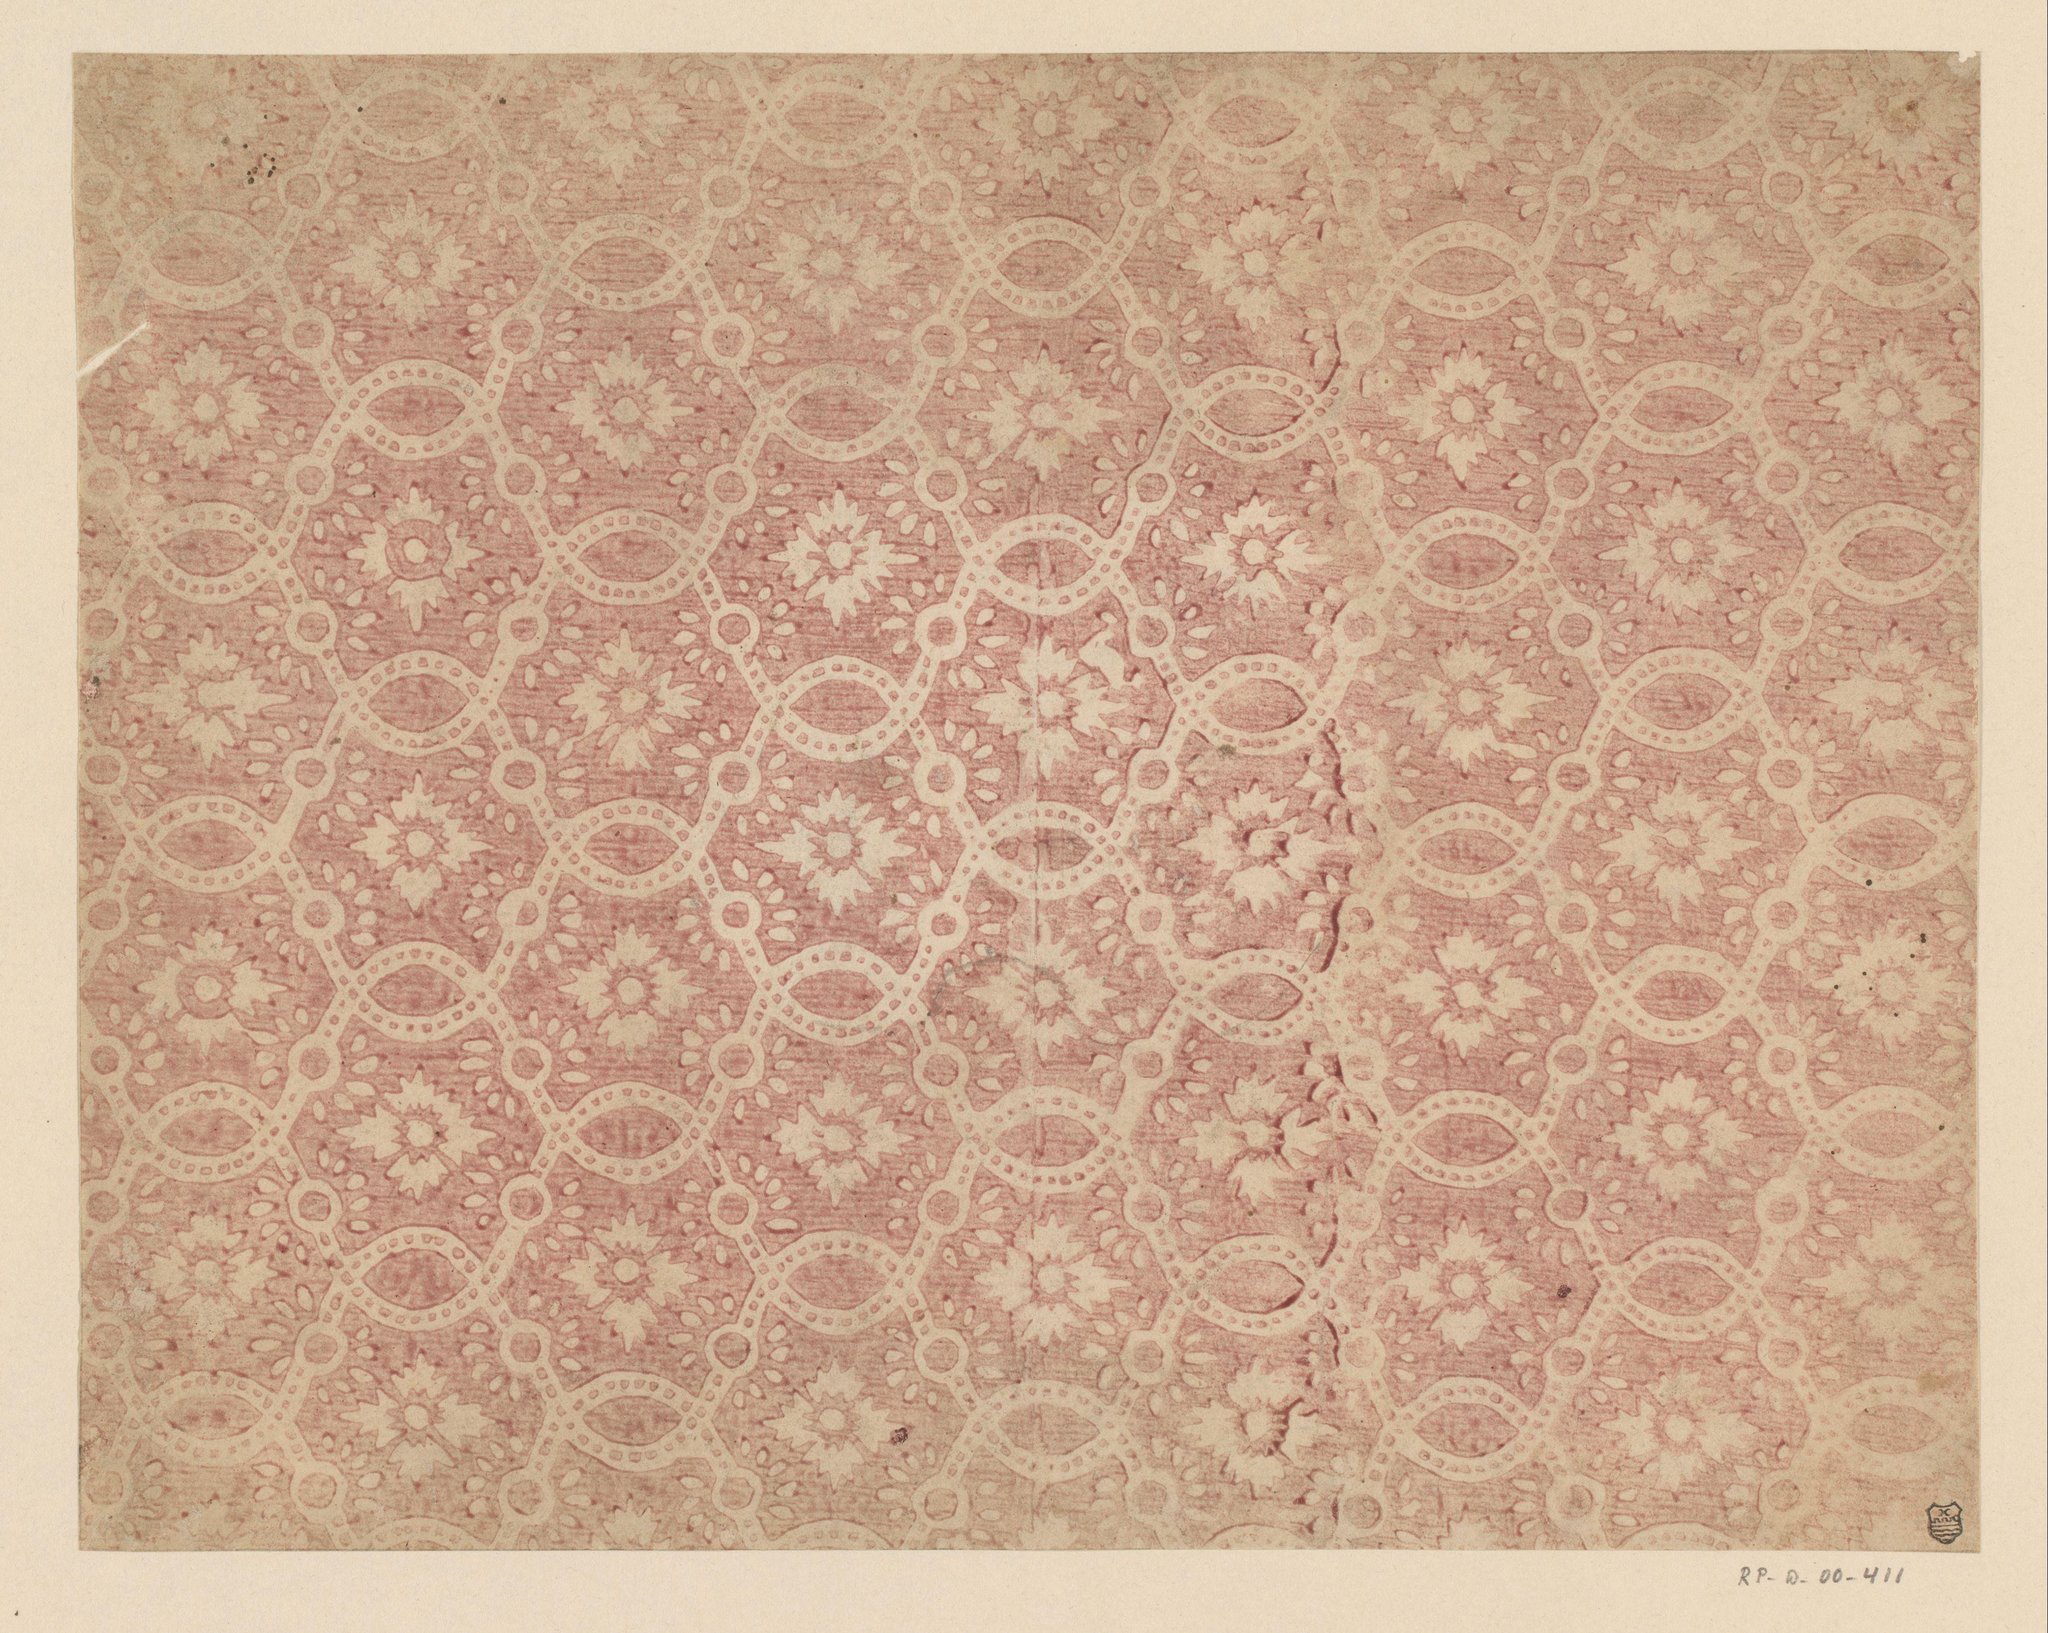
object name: printed paper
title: Blad met strooipatroon van bloem tussen slingerende lijsten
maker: Anonymous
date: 1700-1850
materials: paper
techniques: printing block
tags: ornament derived from plant forms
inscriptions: collector's mark: Lugt 2760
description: Blad met strooipatroon van uitgespaarde bloem tussen slingerende banen.